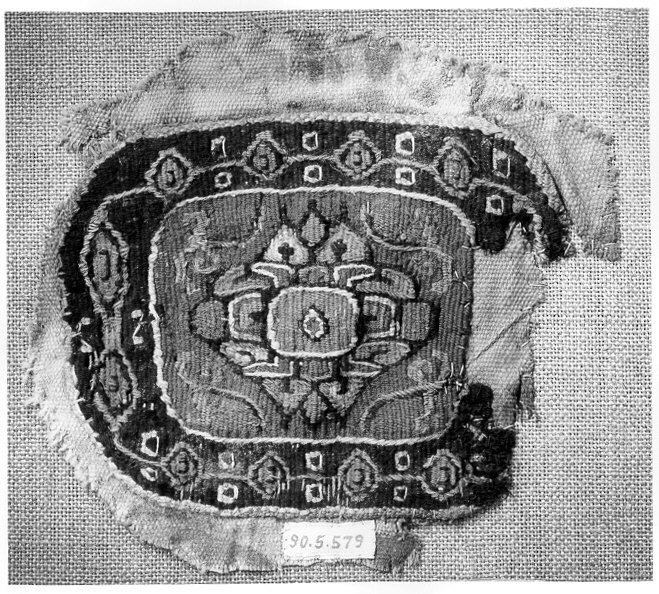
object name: textile fragment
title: Tunic Ornament Showing Christ and the Virgin Flanked by Angels?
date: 601-800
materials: linen, wool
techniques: weave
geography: egypt